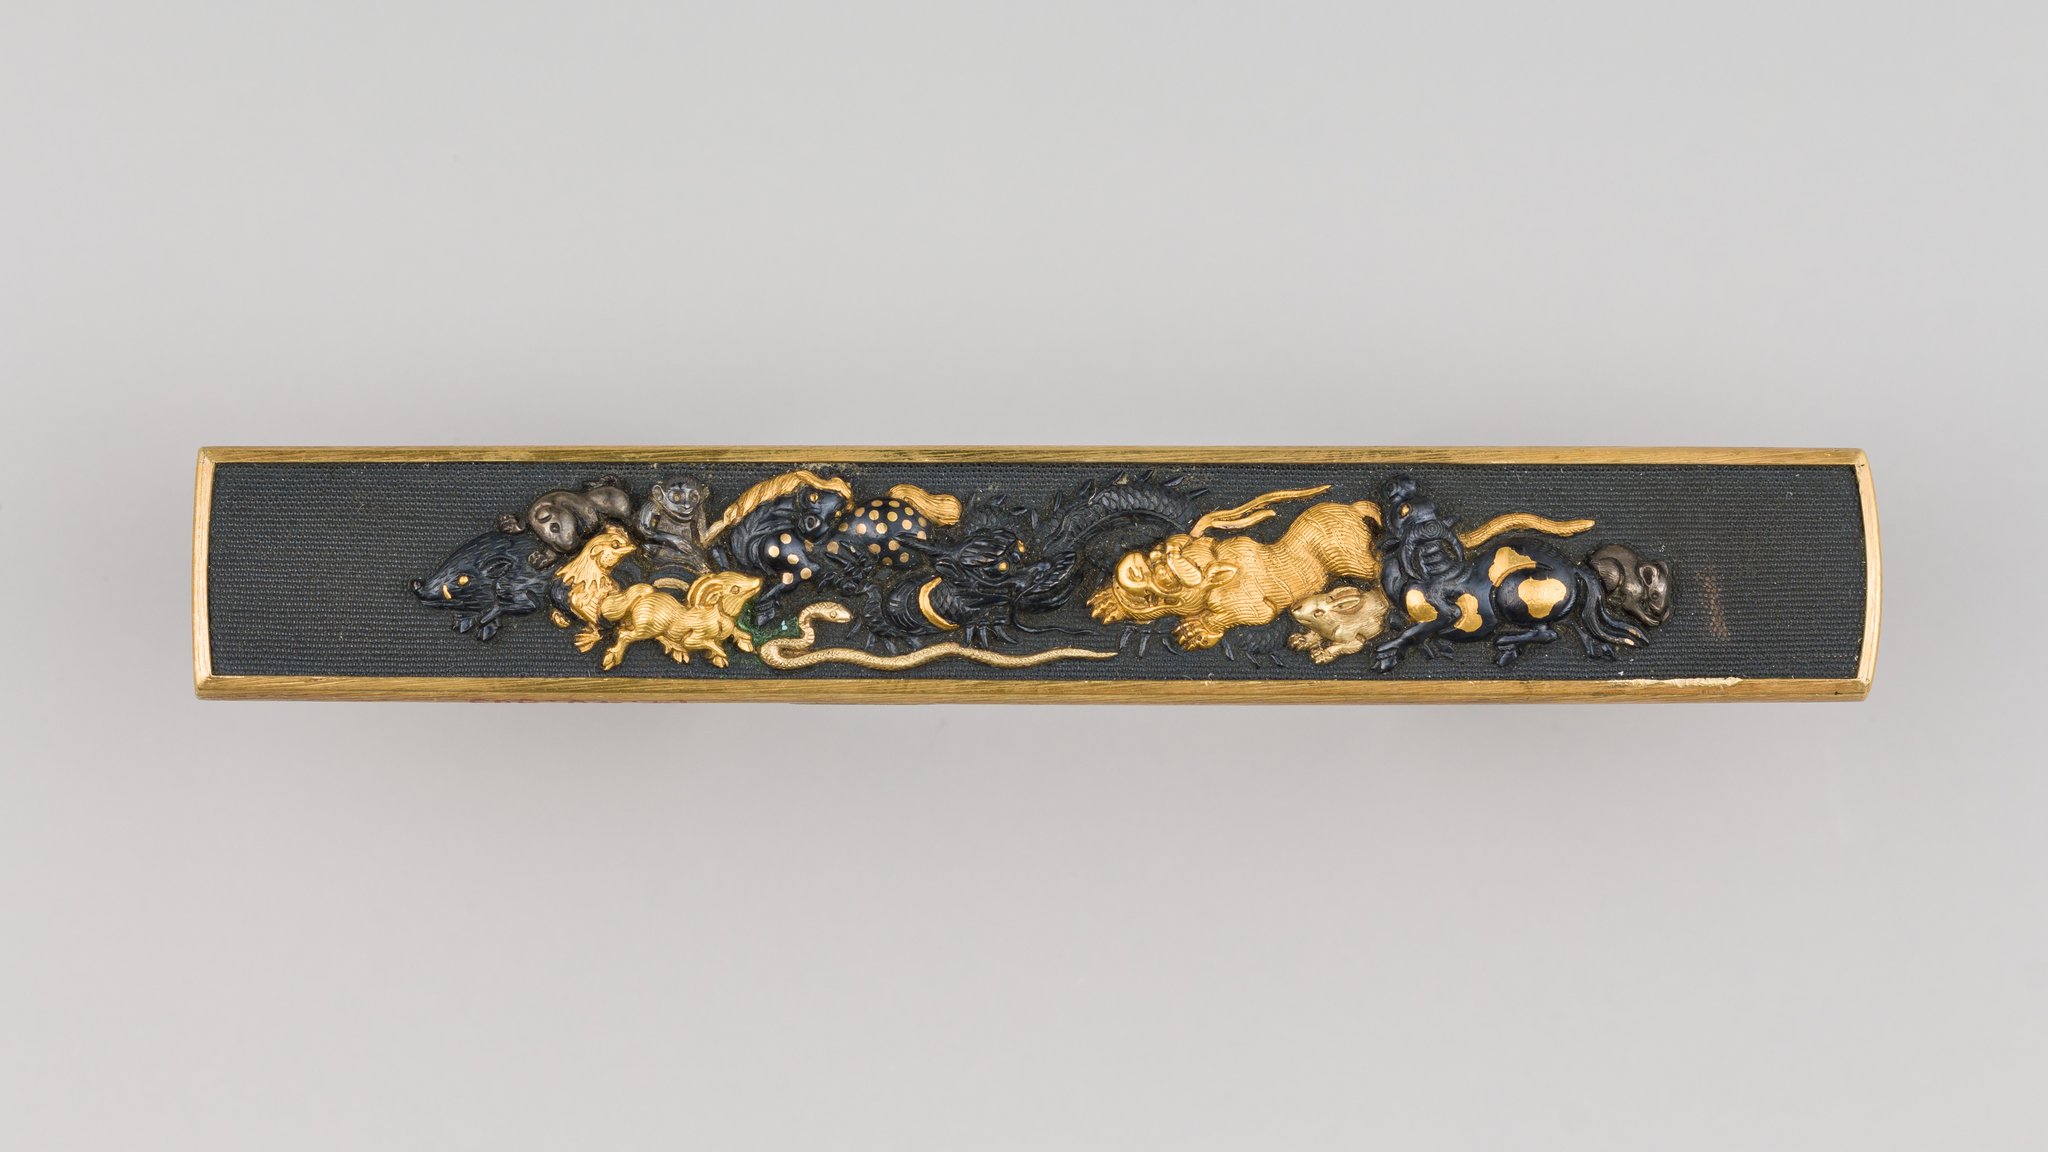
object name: knife handle kozuka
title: Knife Handle (Kozuka)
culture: japanese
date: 1801-1900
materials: gold alloy, silver alloy, gold, silver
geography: japan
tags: dragons,boars,horses,monkeys,rabbits,snakes